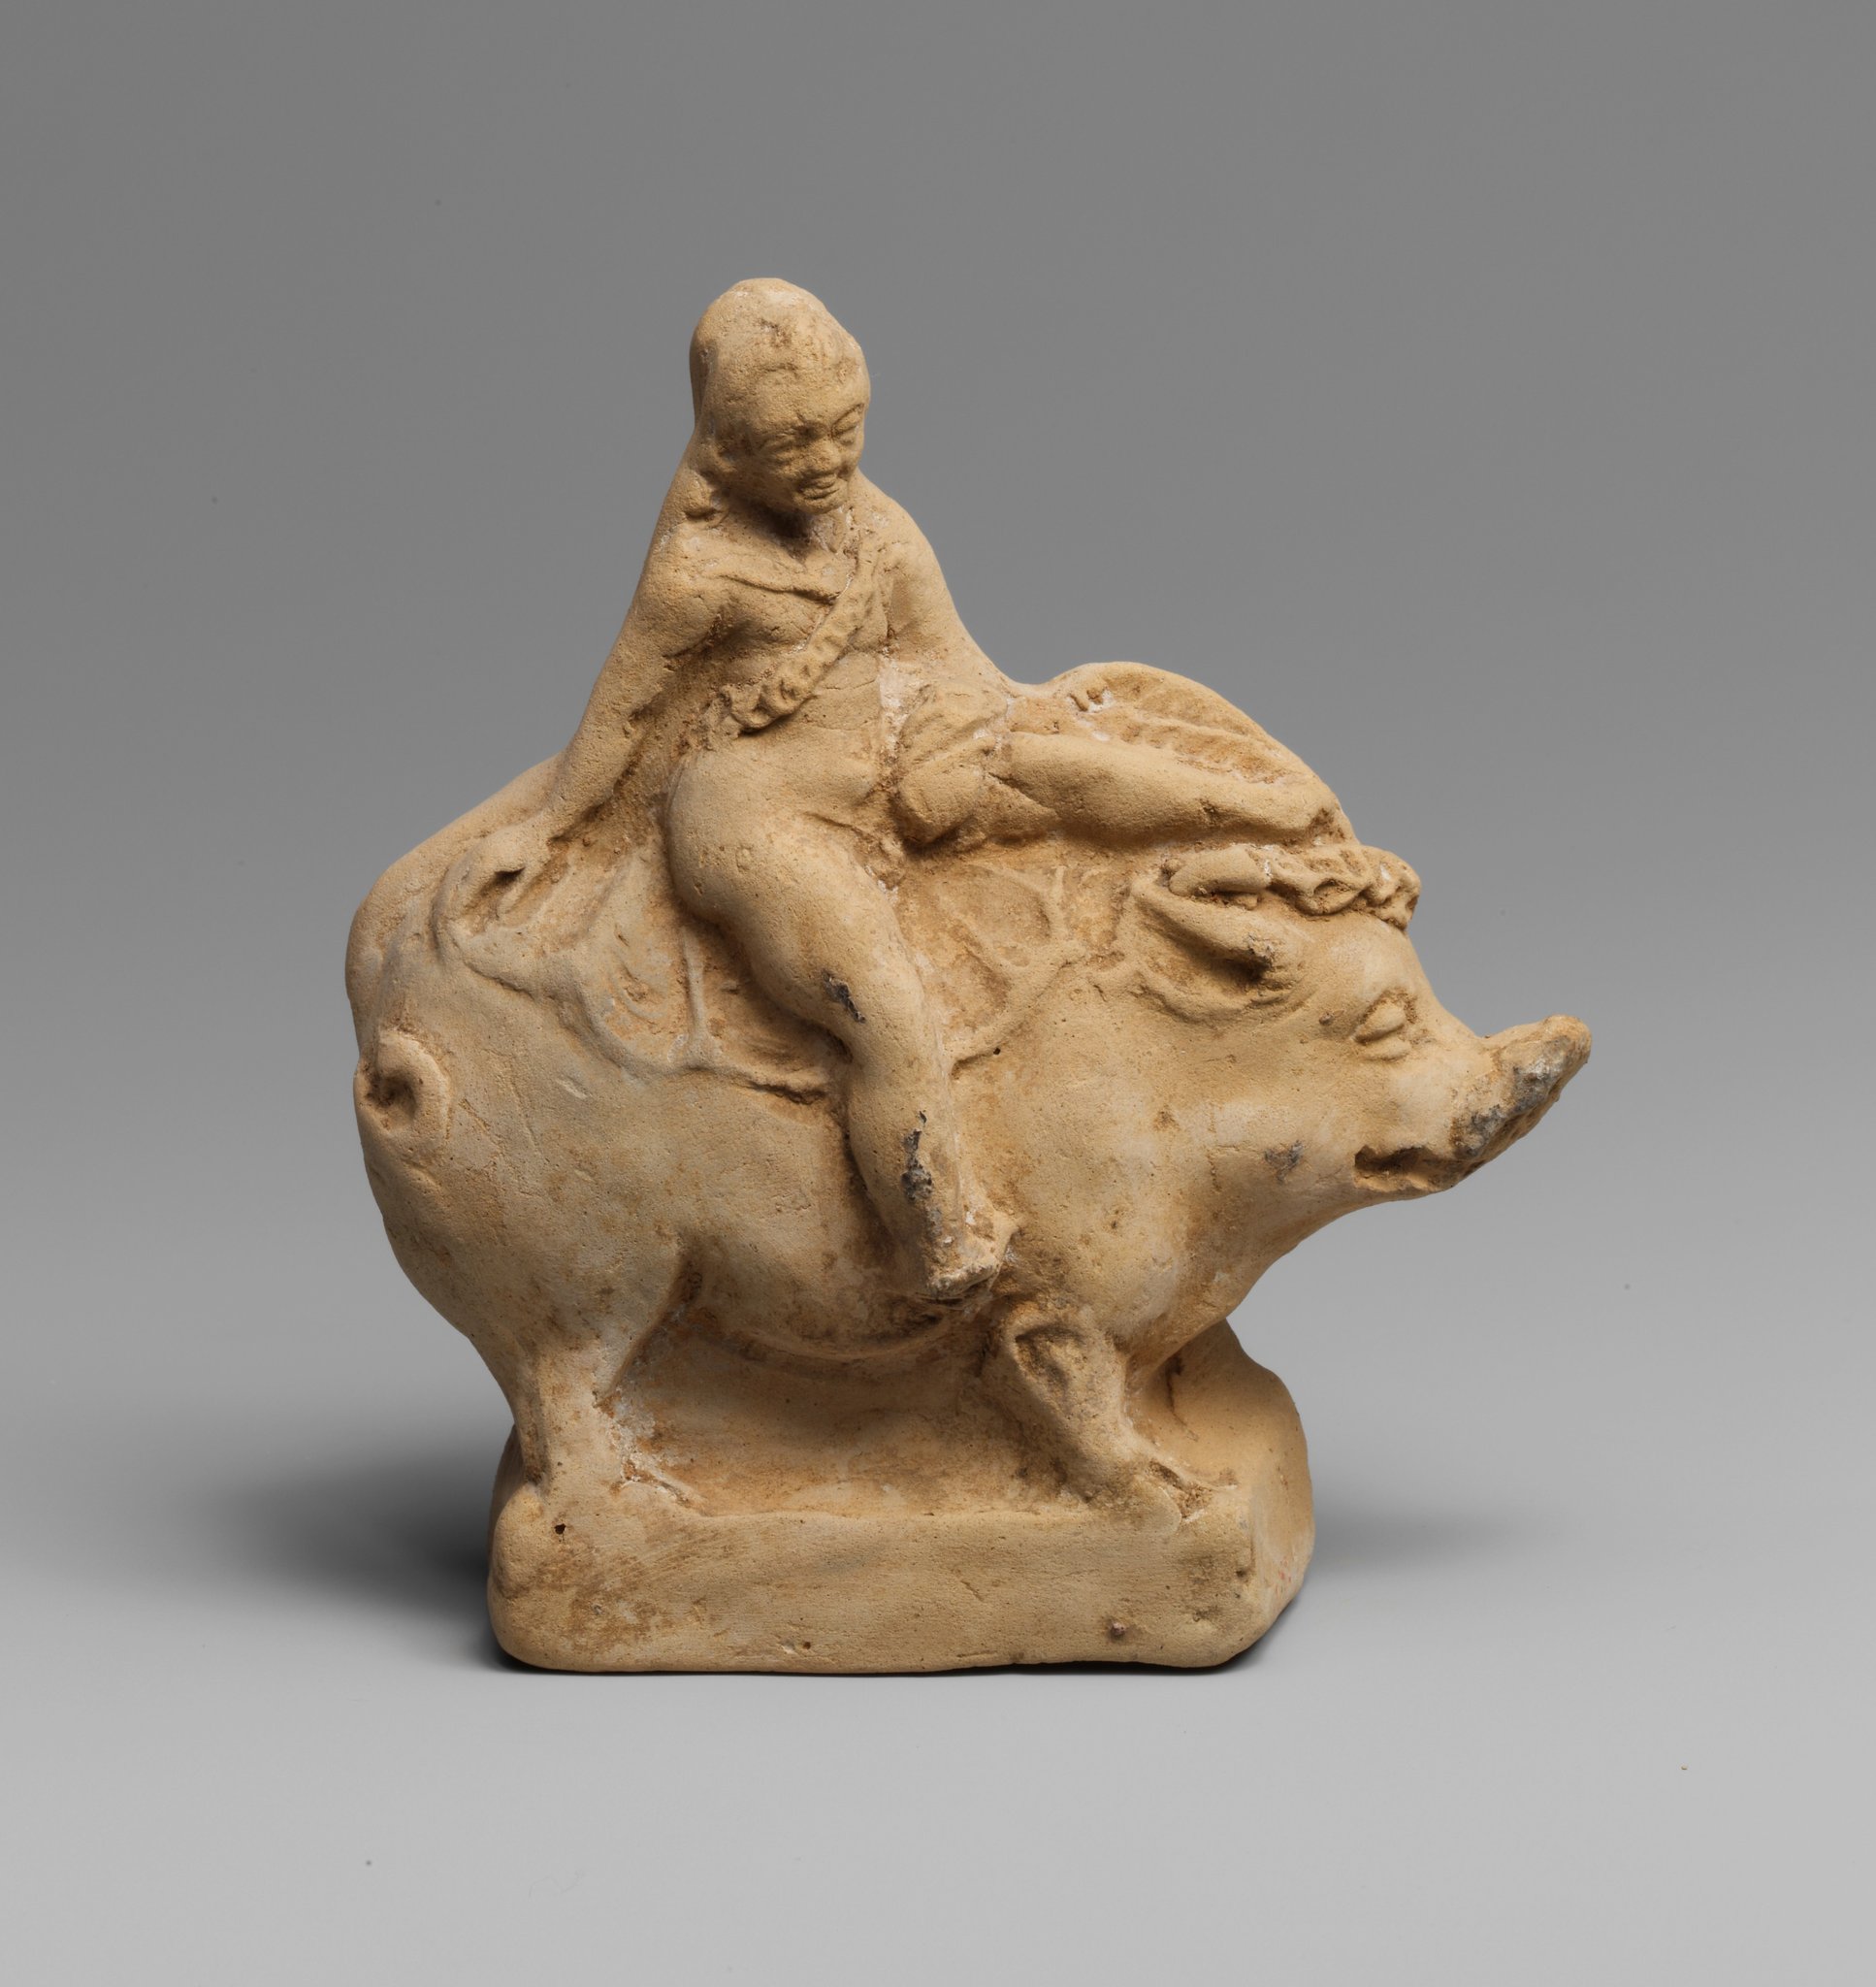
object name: statuette of eros on a boar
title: Terracotta statuette of Eros on a boar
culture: greek or south italian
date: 300-201 BCE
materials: terracotta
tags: eros,boars